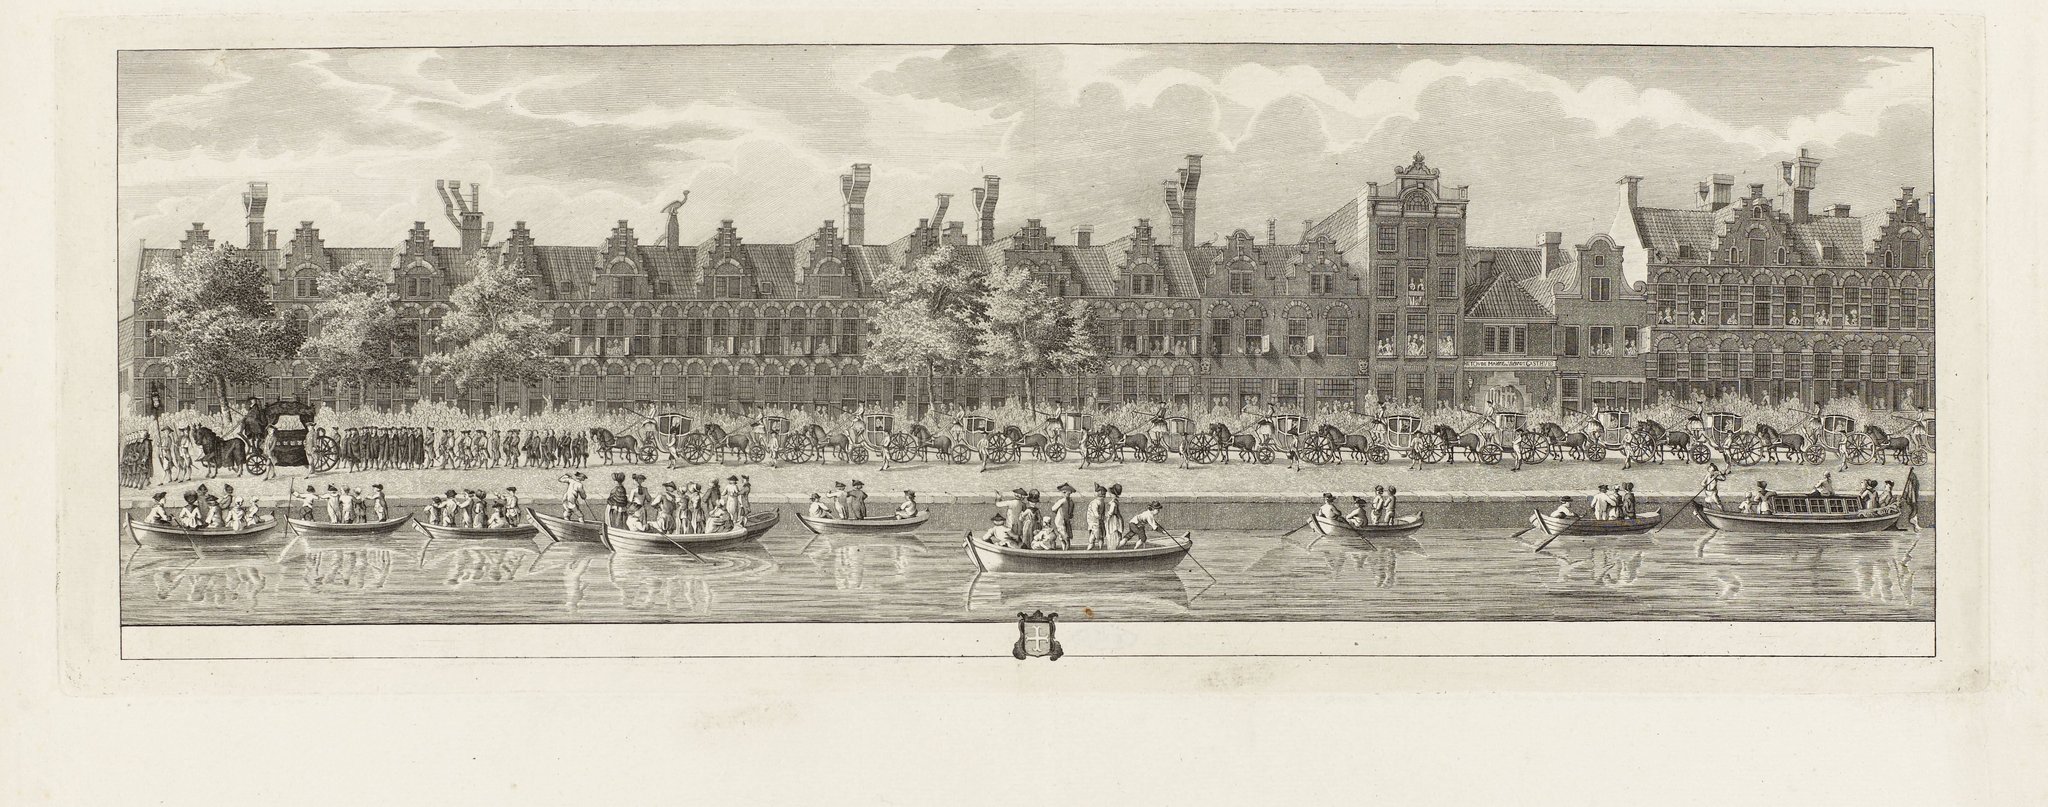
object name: print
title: Lijkstatie van Wolter Jan Gerrit baron Bentinck, 1781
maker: barent de bakker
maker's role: print maker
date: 1781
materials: paper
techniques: engraving, etching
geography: amsterdam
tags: amsterdam, cortege, funeral procession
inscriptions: collector's mark: Lugt 2228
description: Lijkstatie van Wolter Jan Gerrit baron Bentinck, overleden op 23/24 augustus aan zijn verwoningen opgelopen in de zeeslag bij Doggersbank. De lijkstoet trekt op 28 augustus 1781 over de Koveniersburgwal naar de Nieuwe Kerk te Amsterdam.